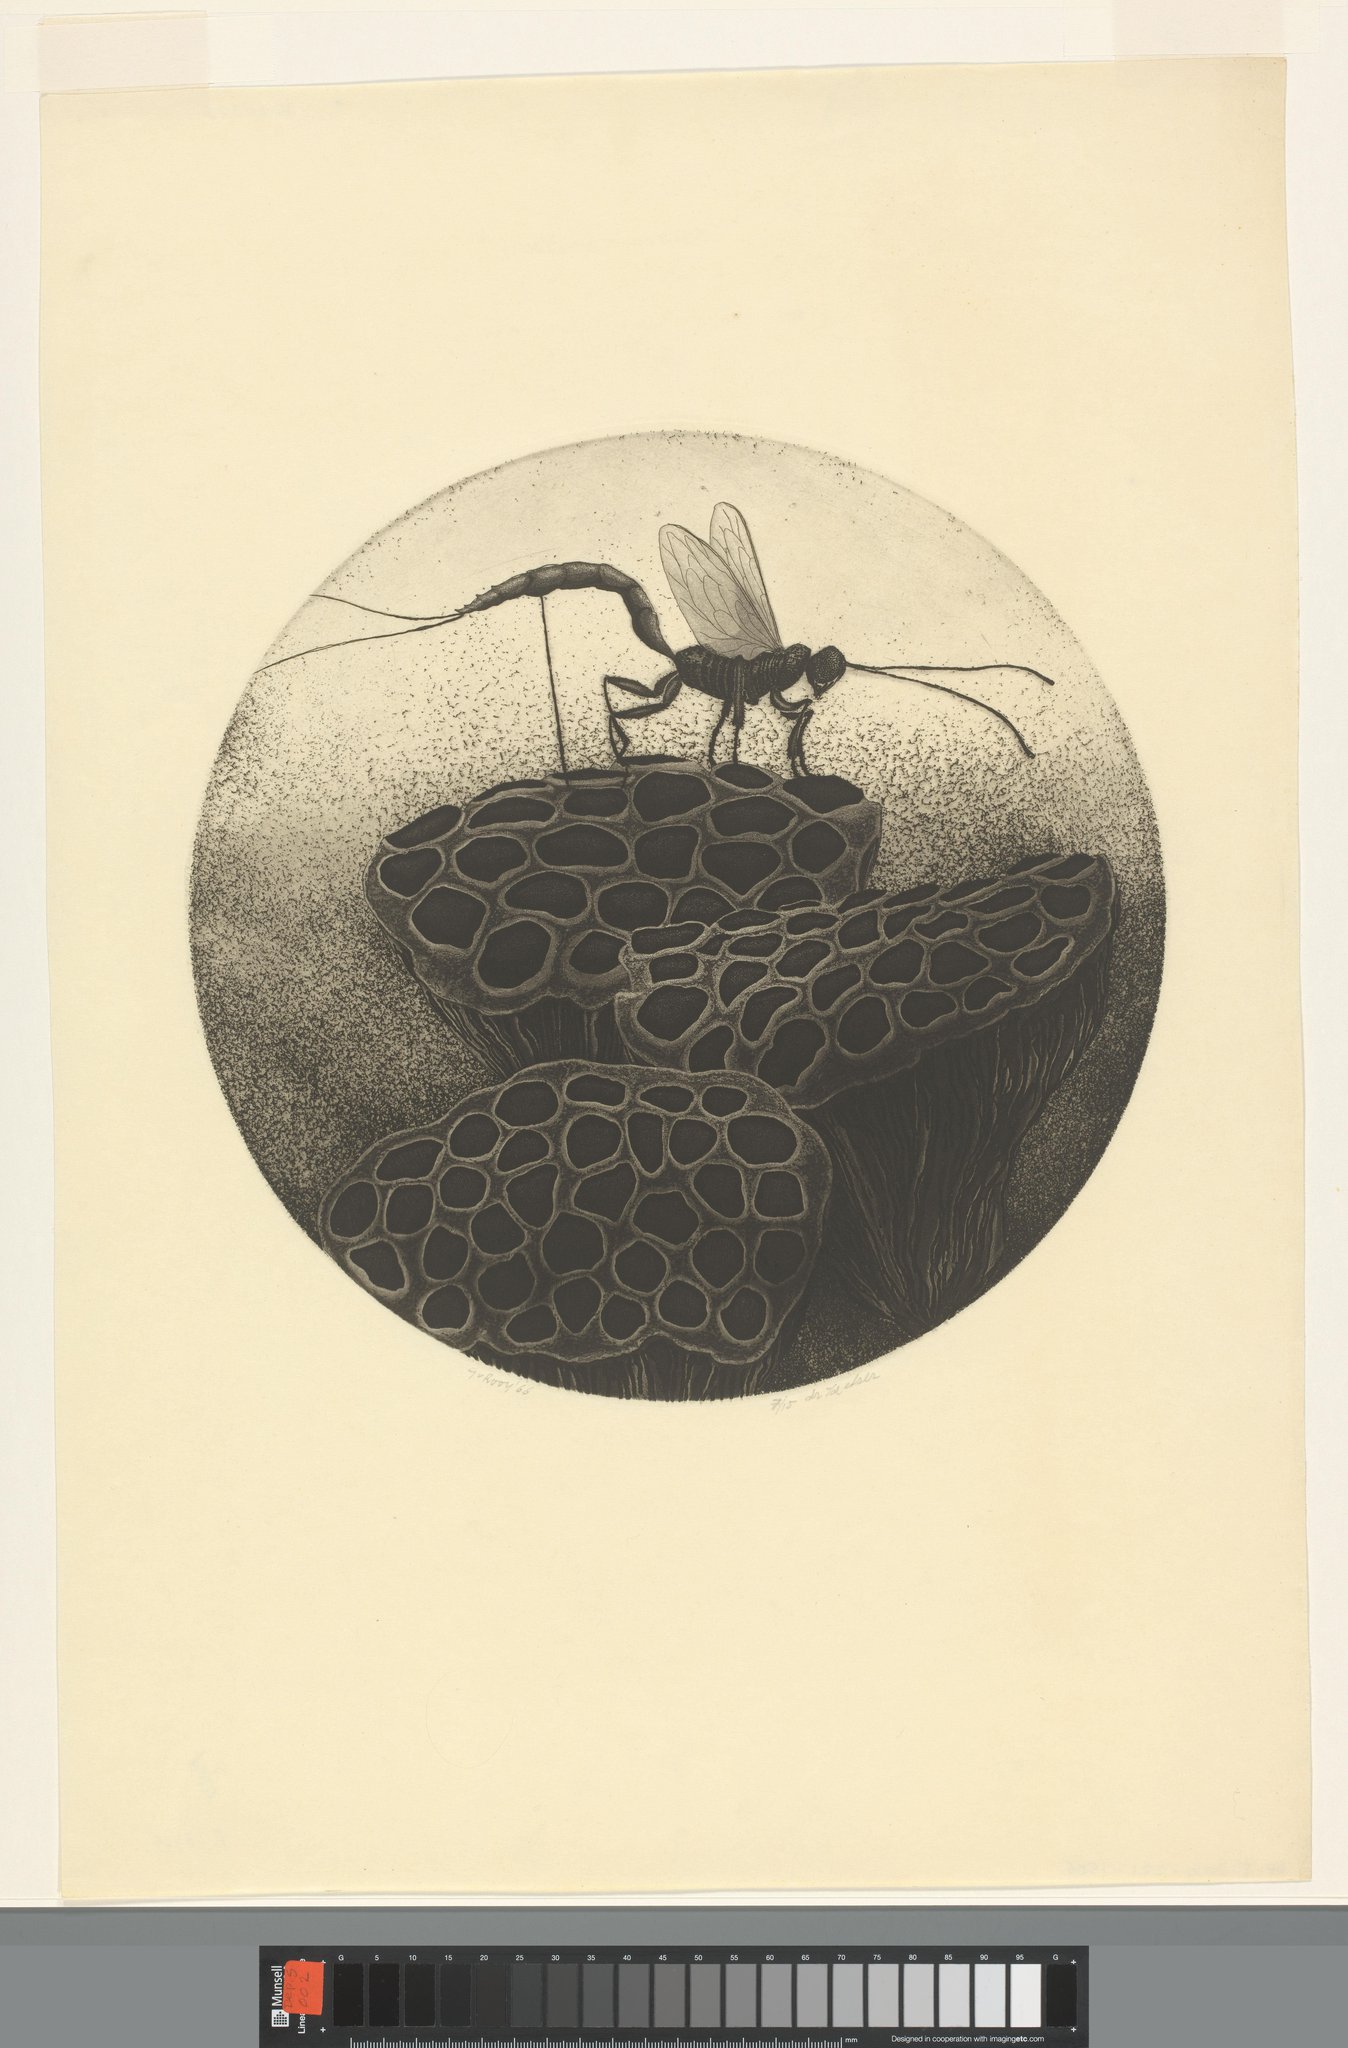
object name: print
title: Sluipwesp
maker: gerard van rooy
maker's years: 1938-2006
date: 1966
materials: paper, ink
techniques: aquatint, etching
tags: insects: bee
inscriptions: signature and date: ‘G.v.Rooy '66’, edition: ‘7/15 dr v/d etser’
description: De huidige titel is door het Rijksmuseum overgenomen van het Instituut Collectie Nederland.